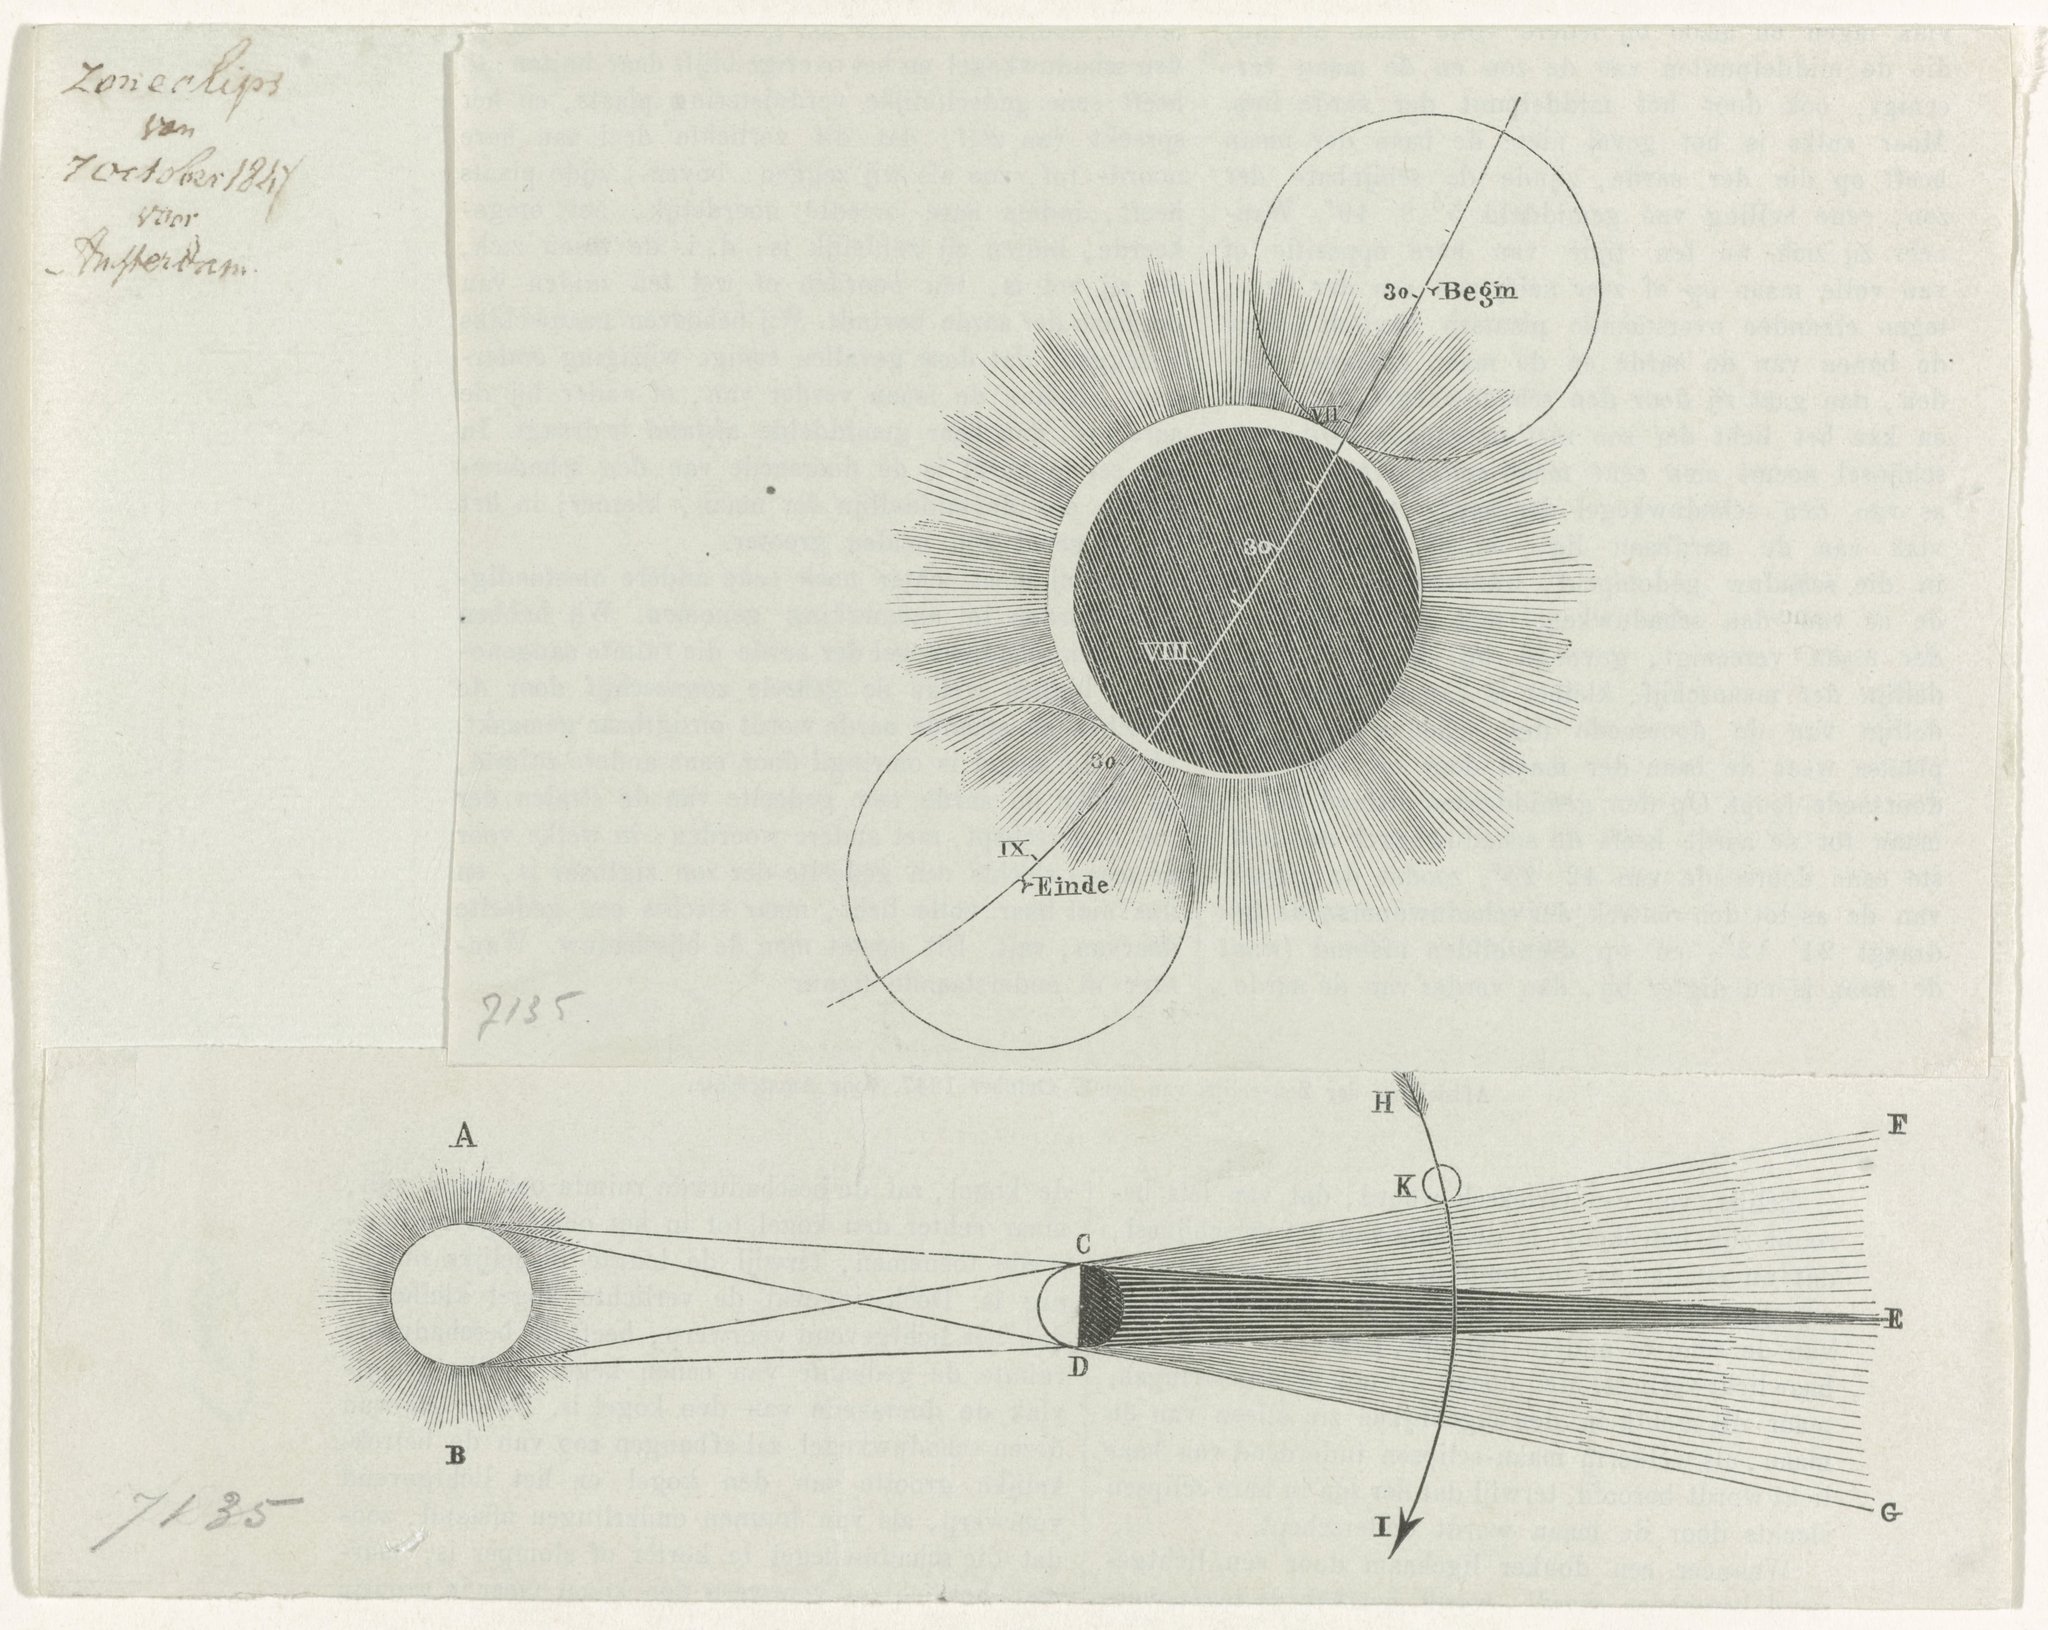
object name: print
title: Zonsverduistering van 9 oktober 1847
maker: Anonymous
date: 1847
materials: paper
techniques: lithograph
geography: netherlands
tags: solar eclipse, amsterdam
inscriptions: collector's mark: Lugt 2228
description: Zonsverduistering van 9 oktober 1847, zoals te zien in Amsterdam. Blad waarop twee uitgeknipte schematische illustraties van eclips zijn geplakt. Beide illustraties met gedrukte tekst op de achterzijde.